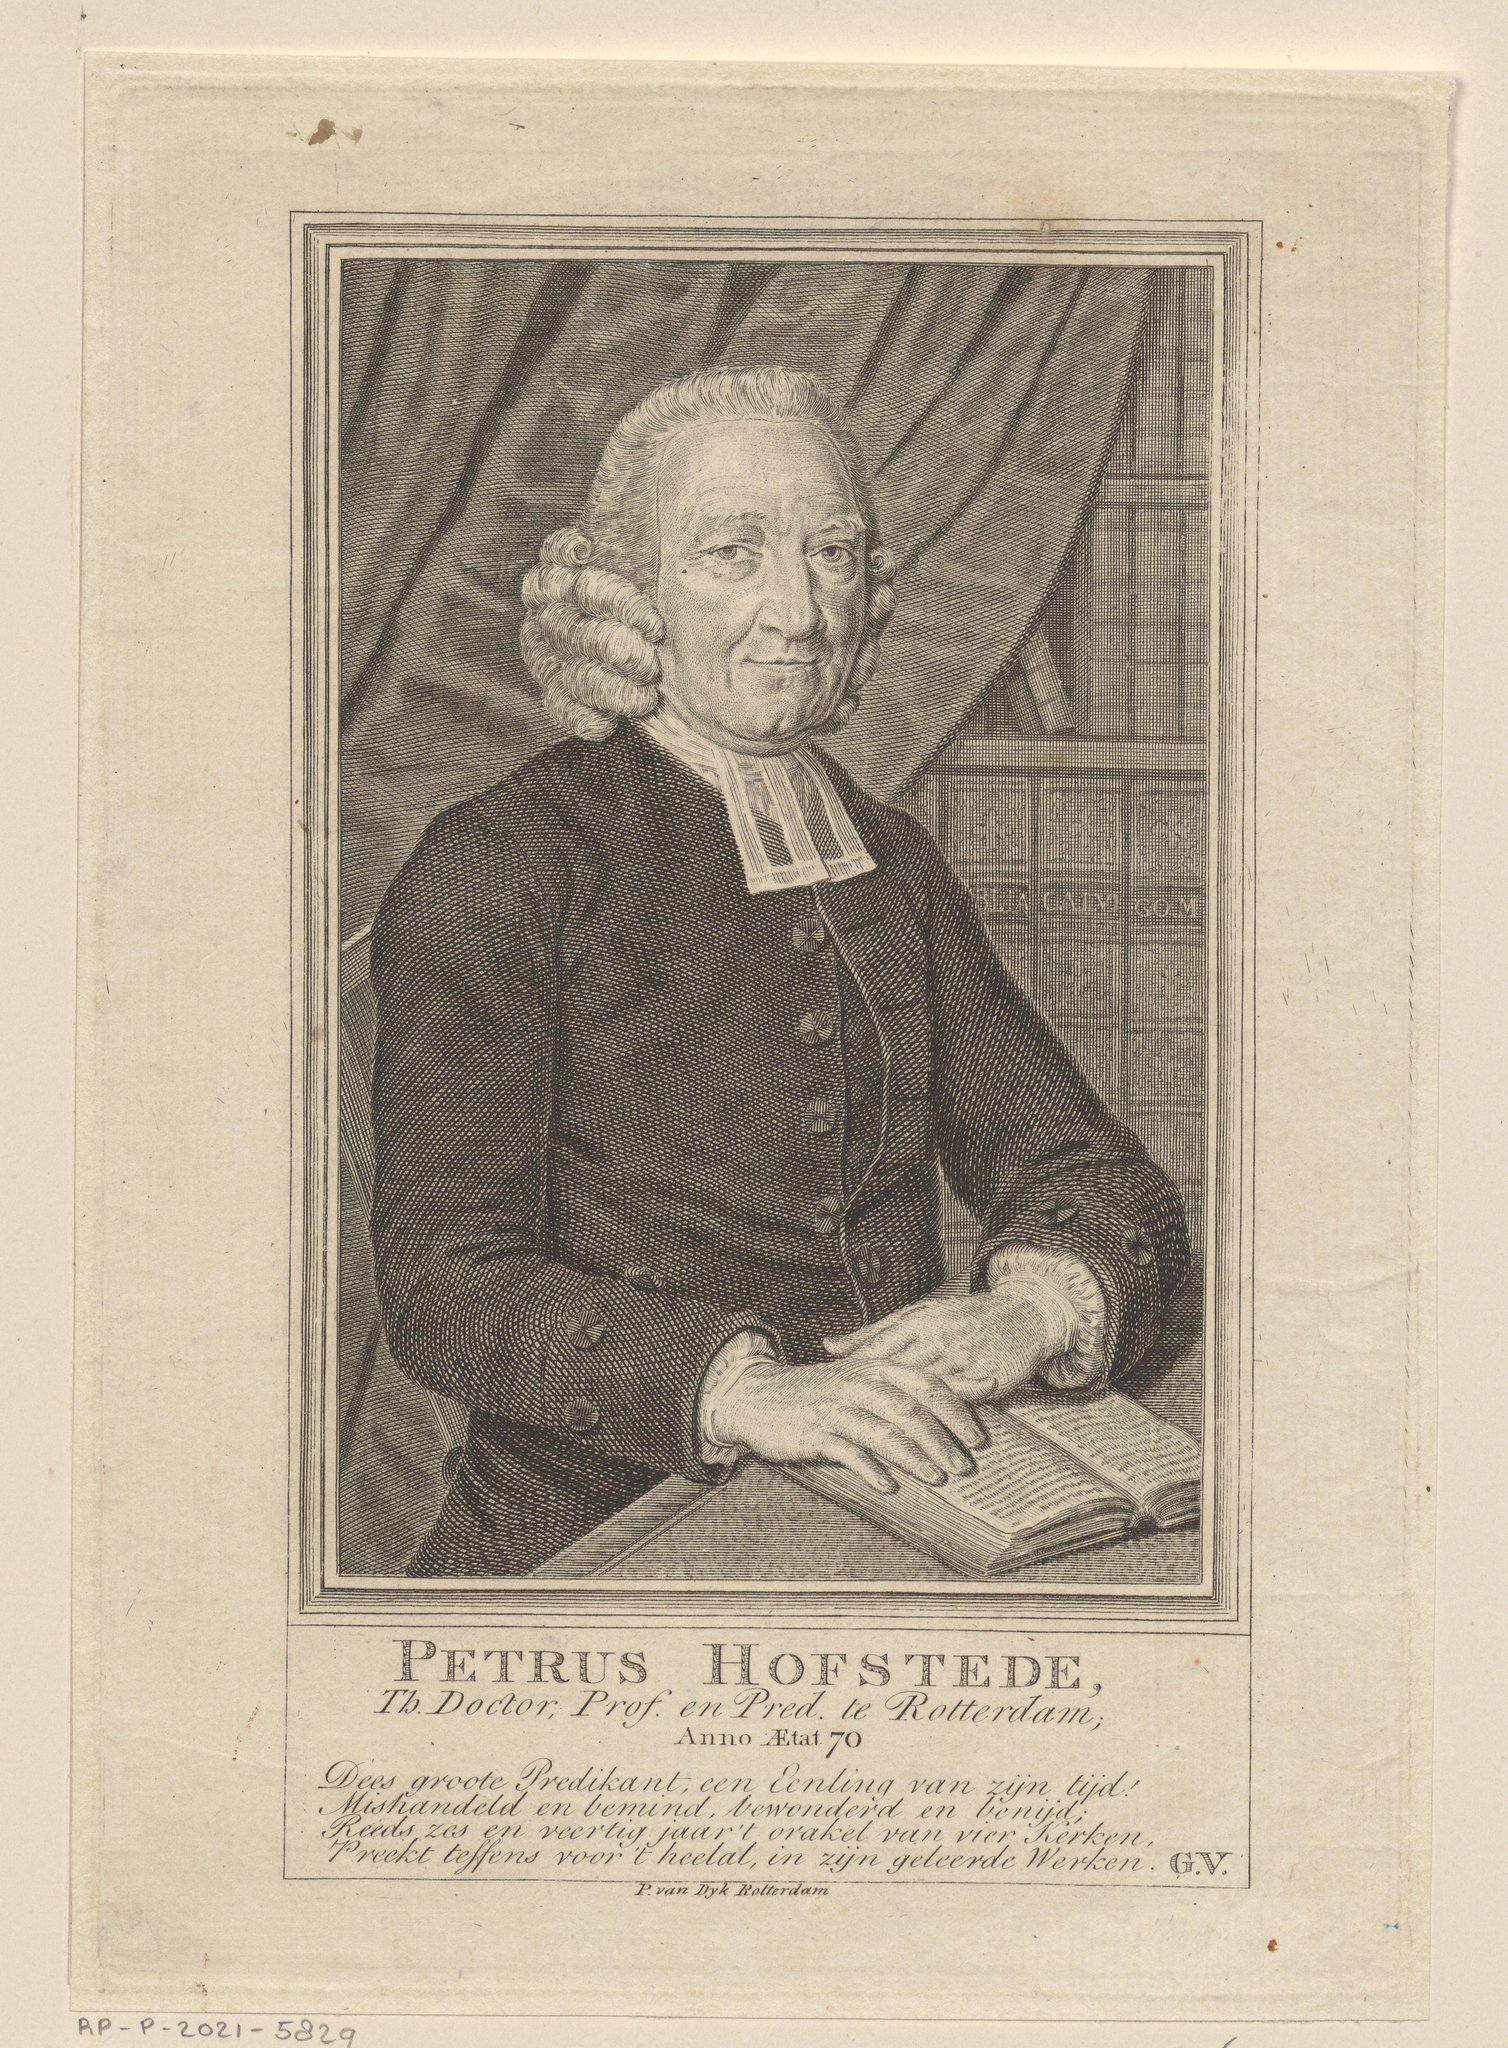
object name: print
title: Portret van Petrus Hofstede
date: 1786-1799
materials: paper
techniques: engraving, etching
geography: rotterdam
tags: rotterdam, petrus hofstede, historical persons, book